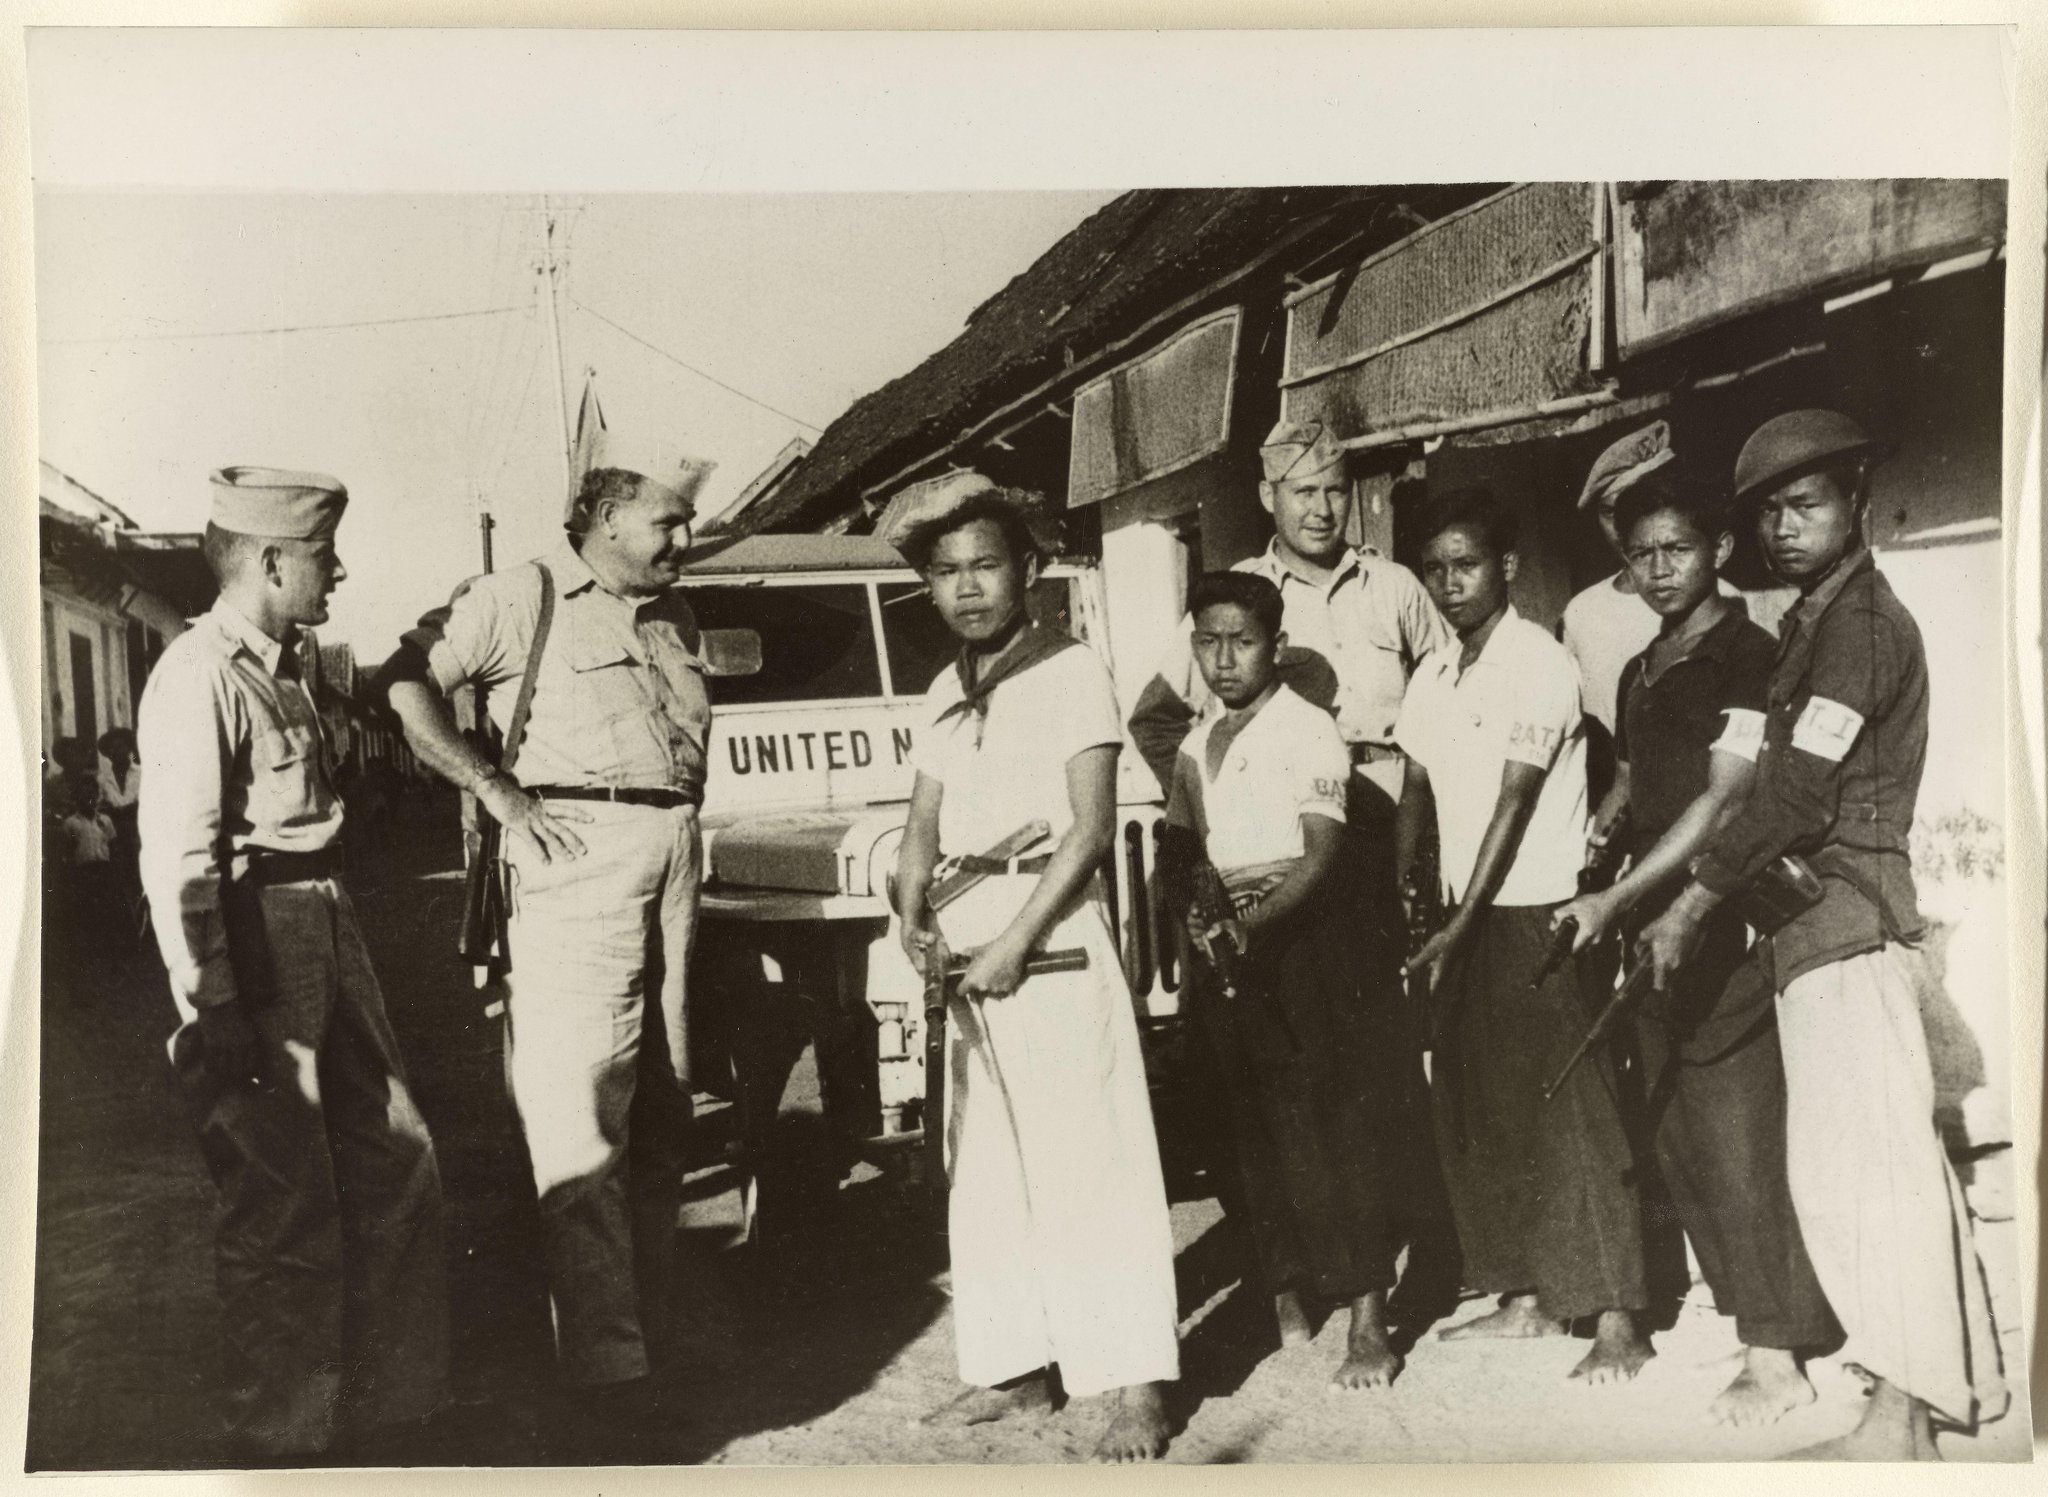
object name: documentary photograph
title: Republikeinse guerillas nemen dorpje Kotagede over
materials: photographic support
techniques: photography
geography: indonesia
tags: united nations, indonesia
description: Drie militaire waarnemers van de Verenigde Naties en een groep Republikeinse soldaten staan gezamenlijk in een straat in Kotagede met op de achtergrond een VN-jeep.